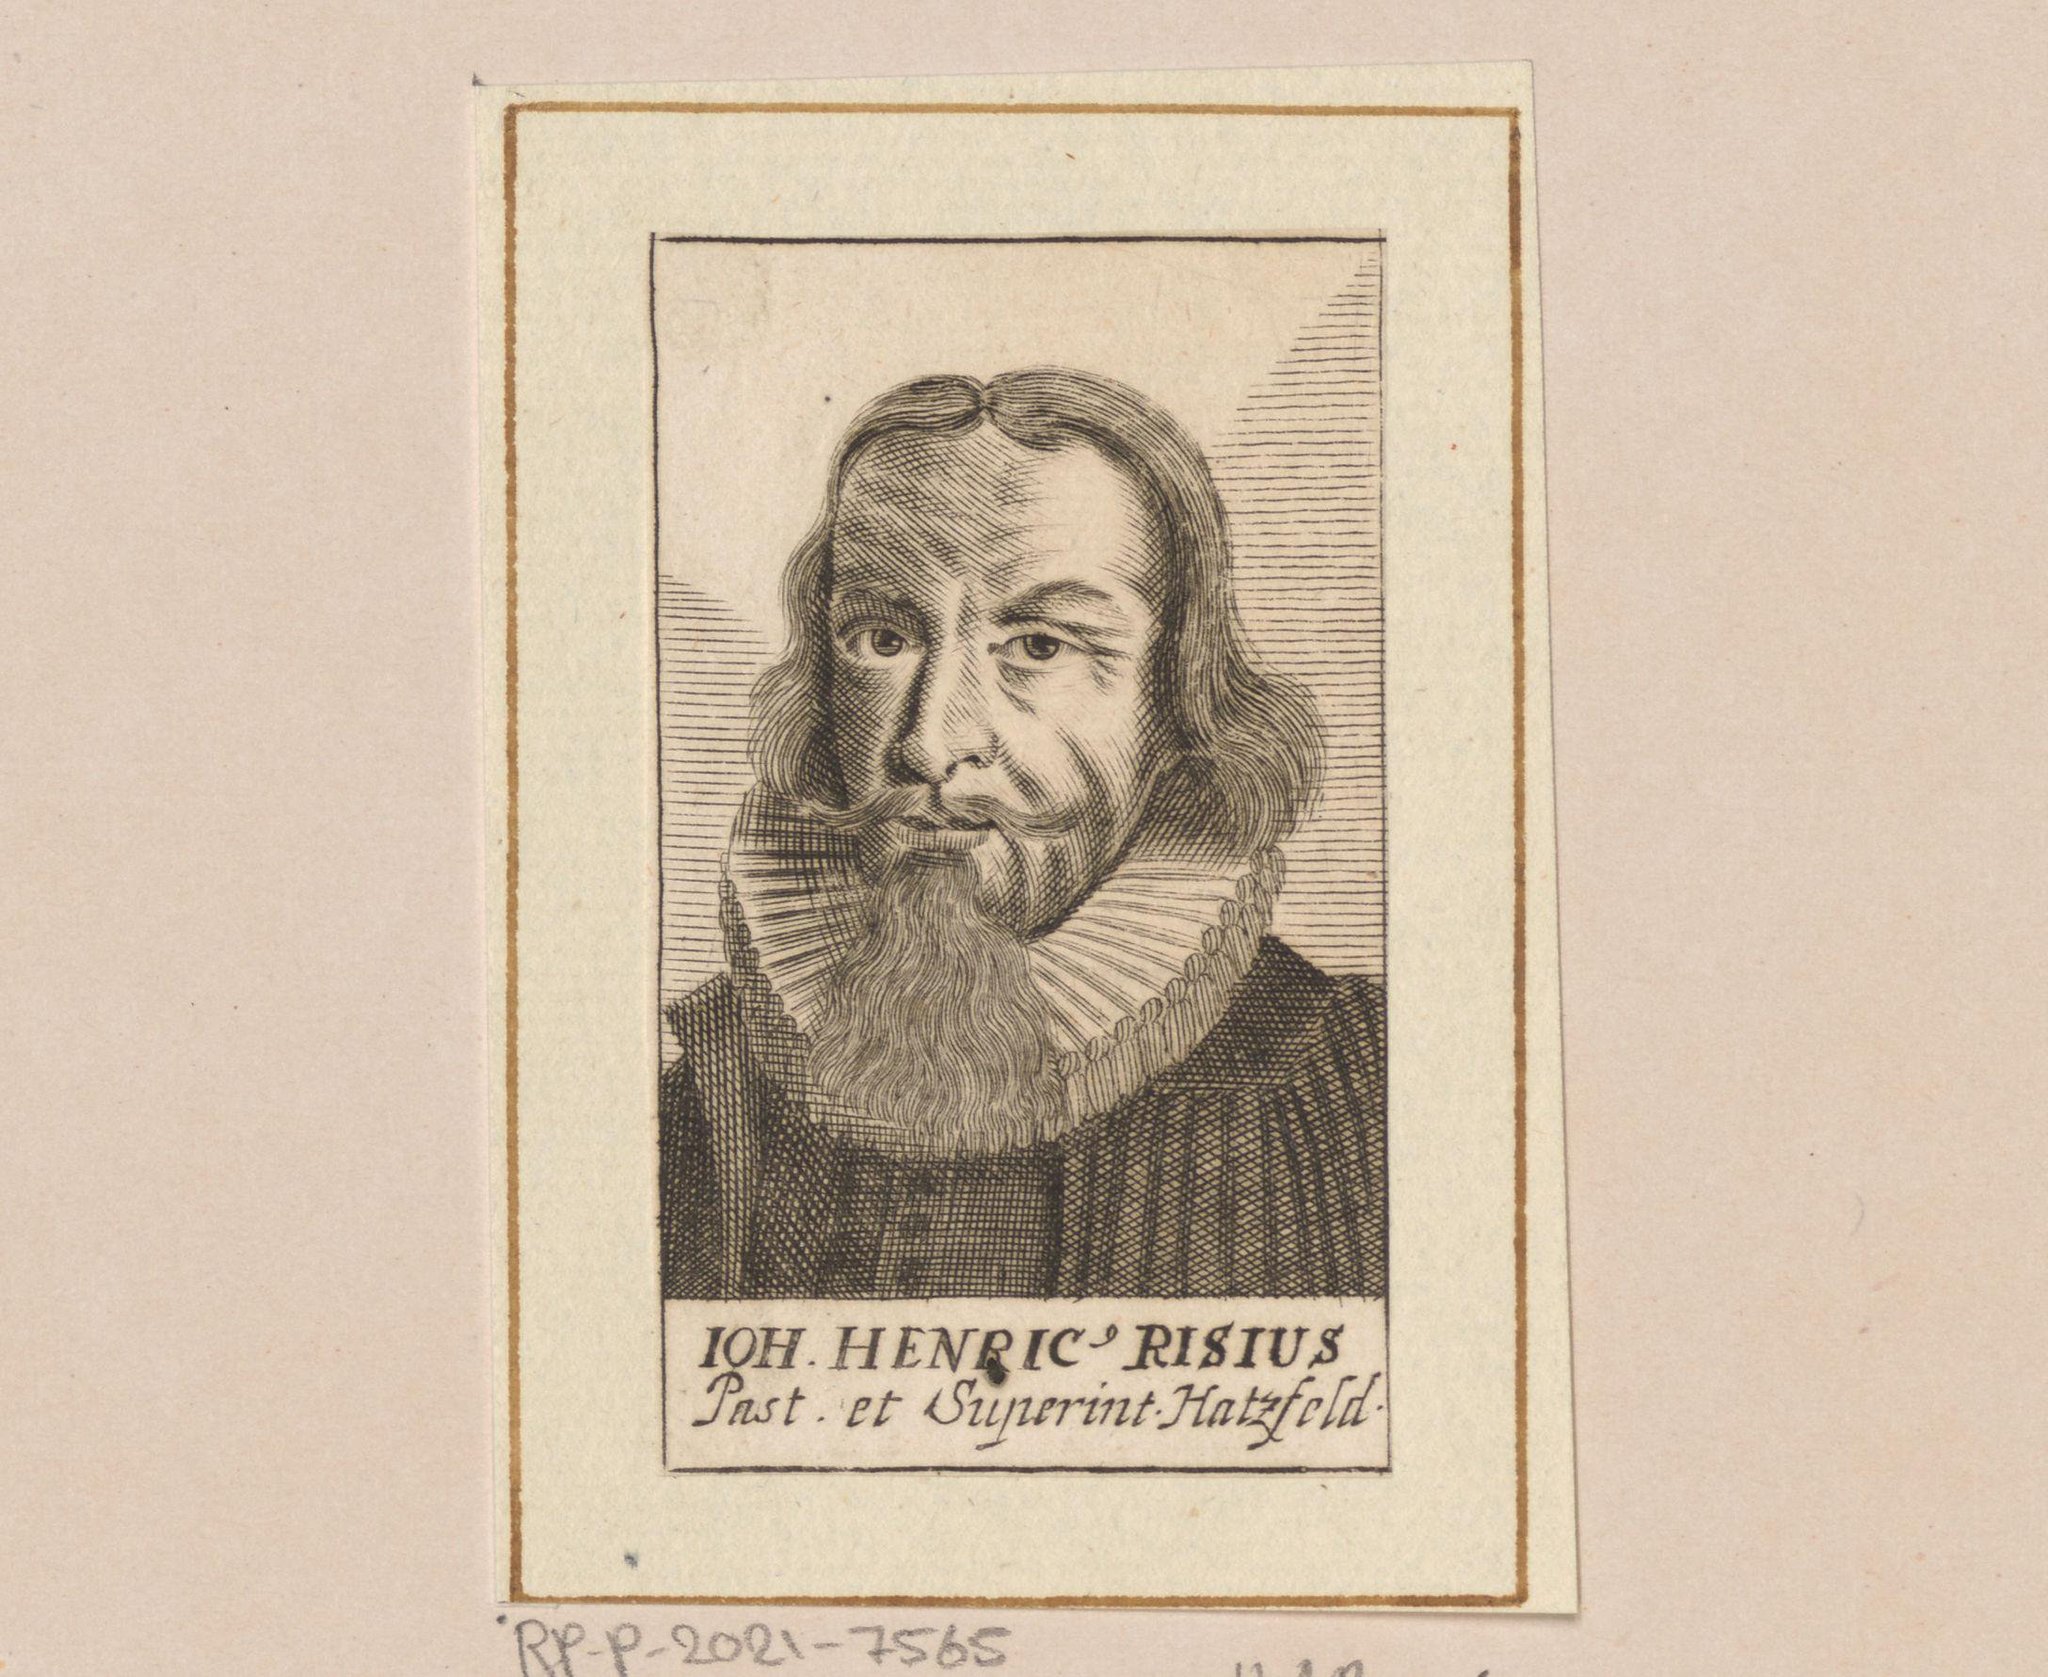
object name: print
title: Portret van Johann Heinrich Risius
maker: Anonymous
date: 1688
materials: paper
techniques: engraving, etching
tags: historical persons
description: Prent maakt deel uit van een grotere prent die later is verknipt. Prent waarschijnlijk uit: Freher, Paul. Theatrum virorum eruditione clarorum. Neurenberg: Johann Hoffmann, 1688.